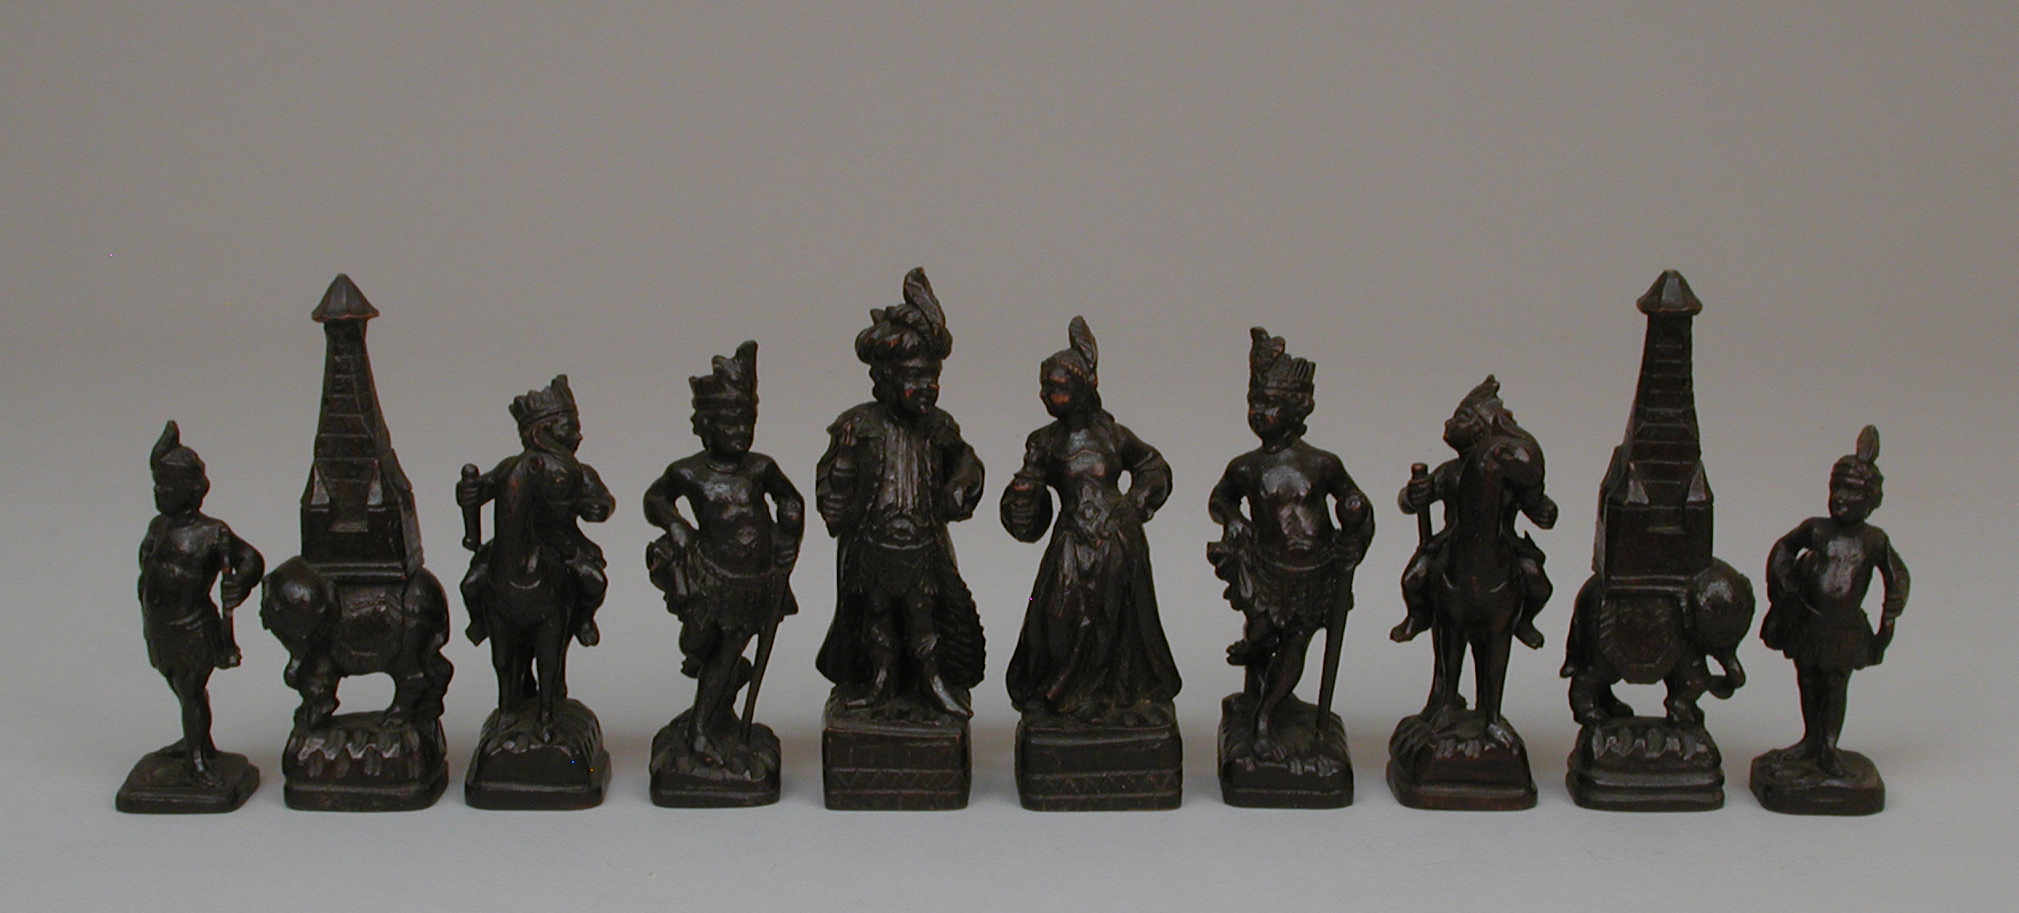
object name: chessman and box board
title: Chessmen (32) and box-board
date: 1801-1900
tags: chess